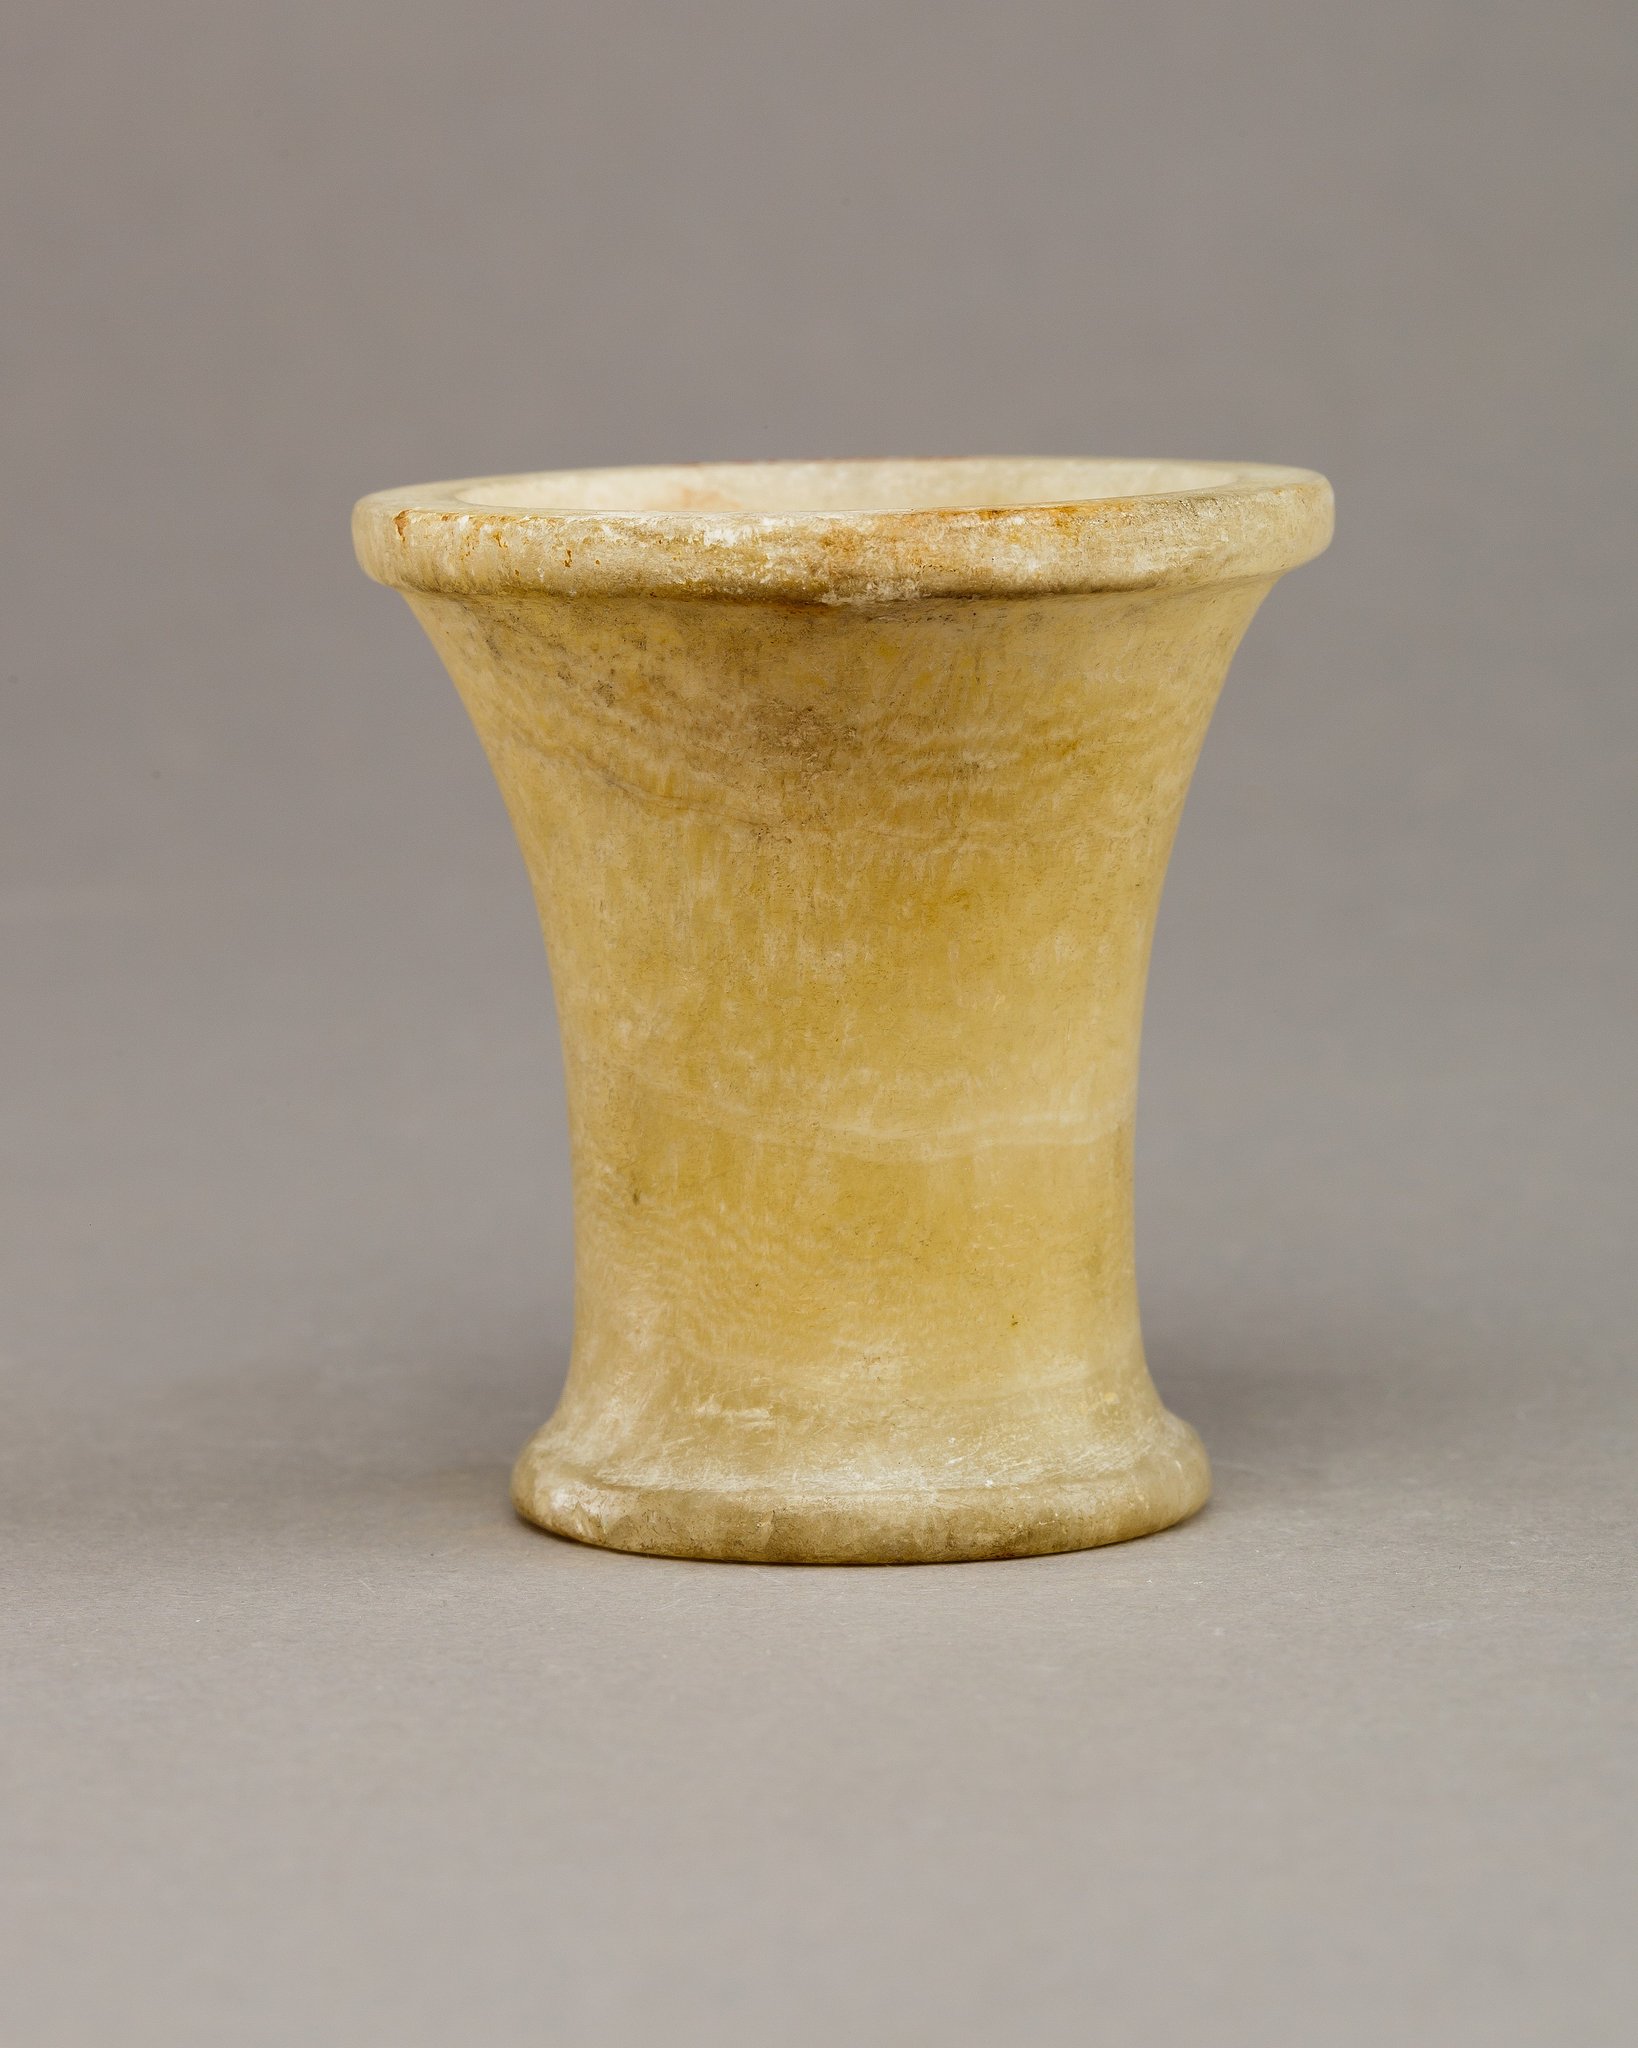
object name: ointment jar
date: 1981-1952 BCE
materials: stone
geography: egypt